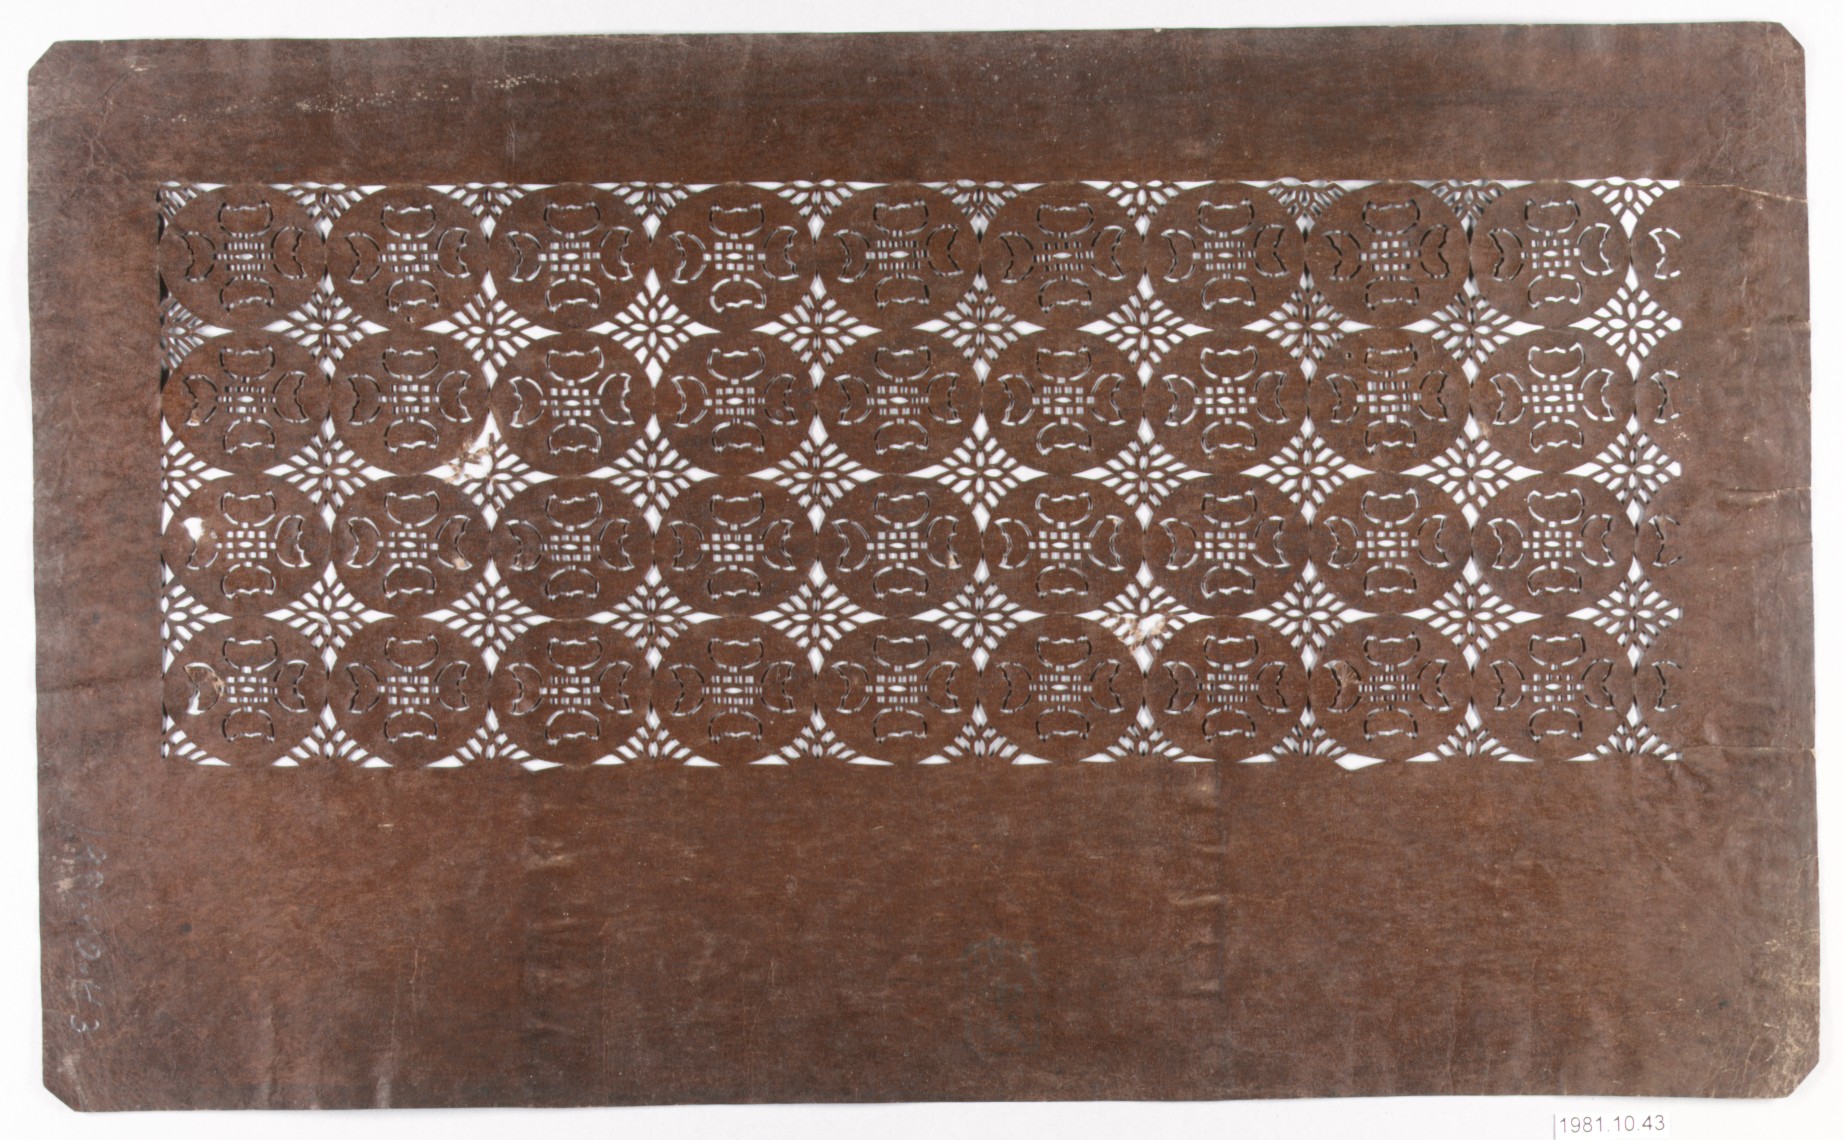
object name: stencil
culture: japanese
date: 1801-1900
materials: paper